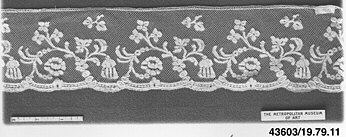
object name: strip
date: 1801-1833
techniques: lace